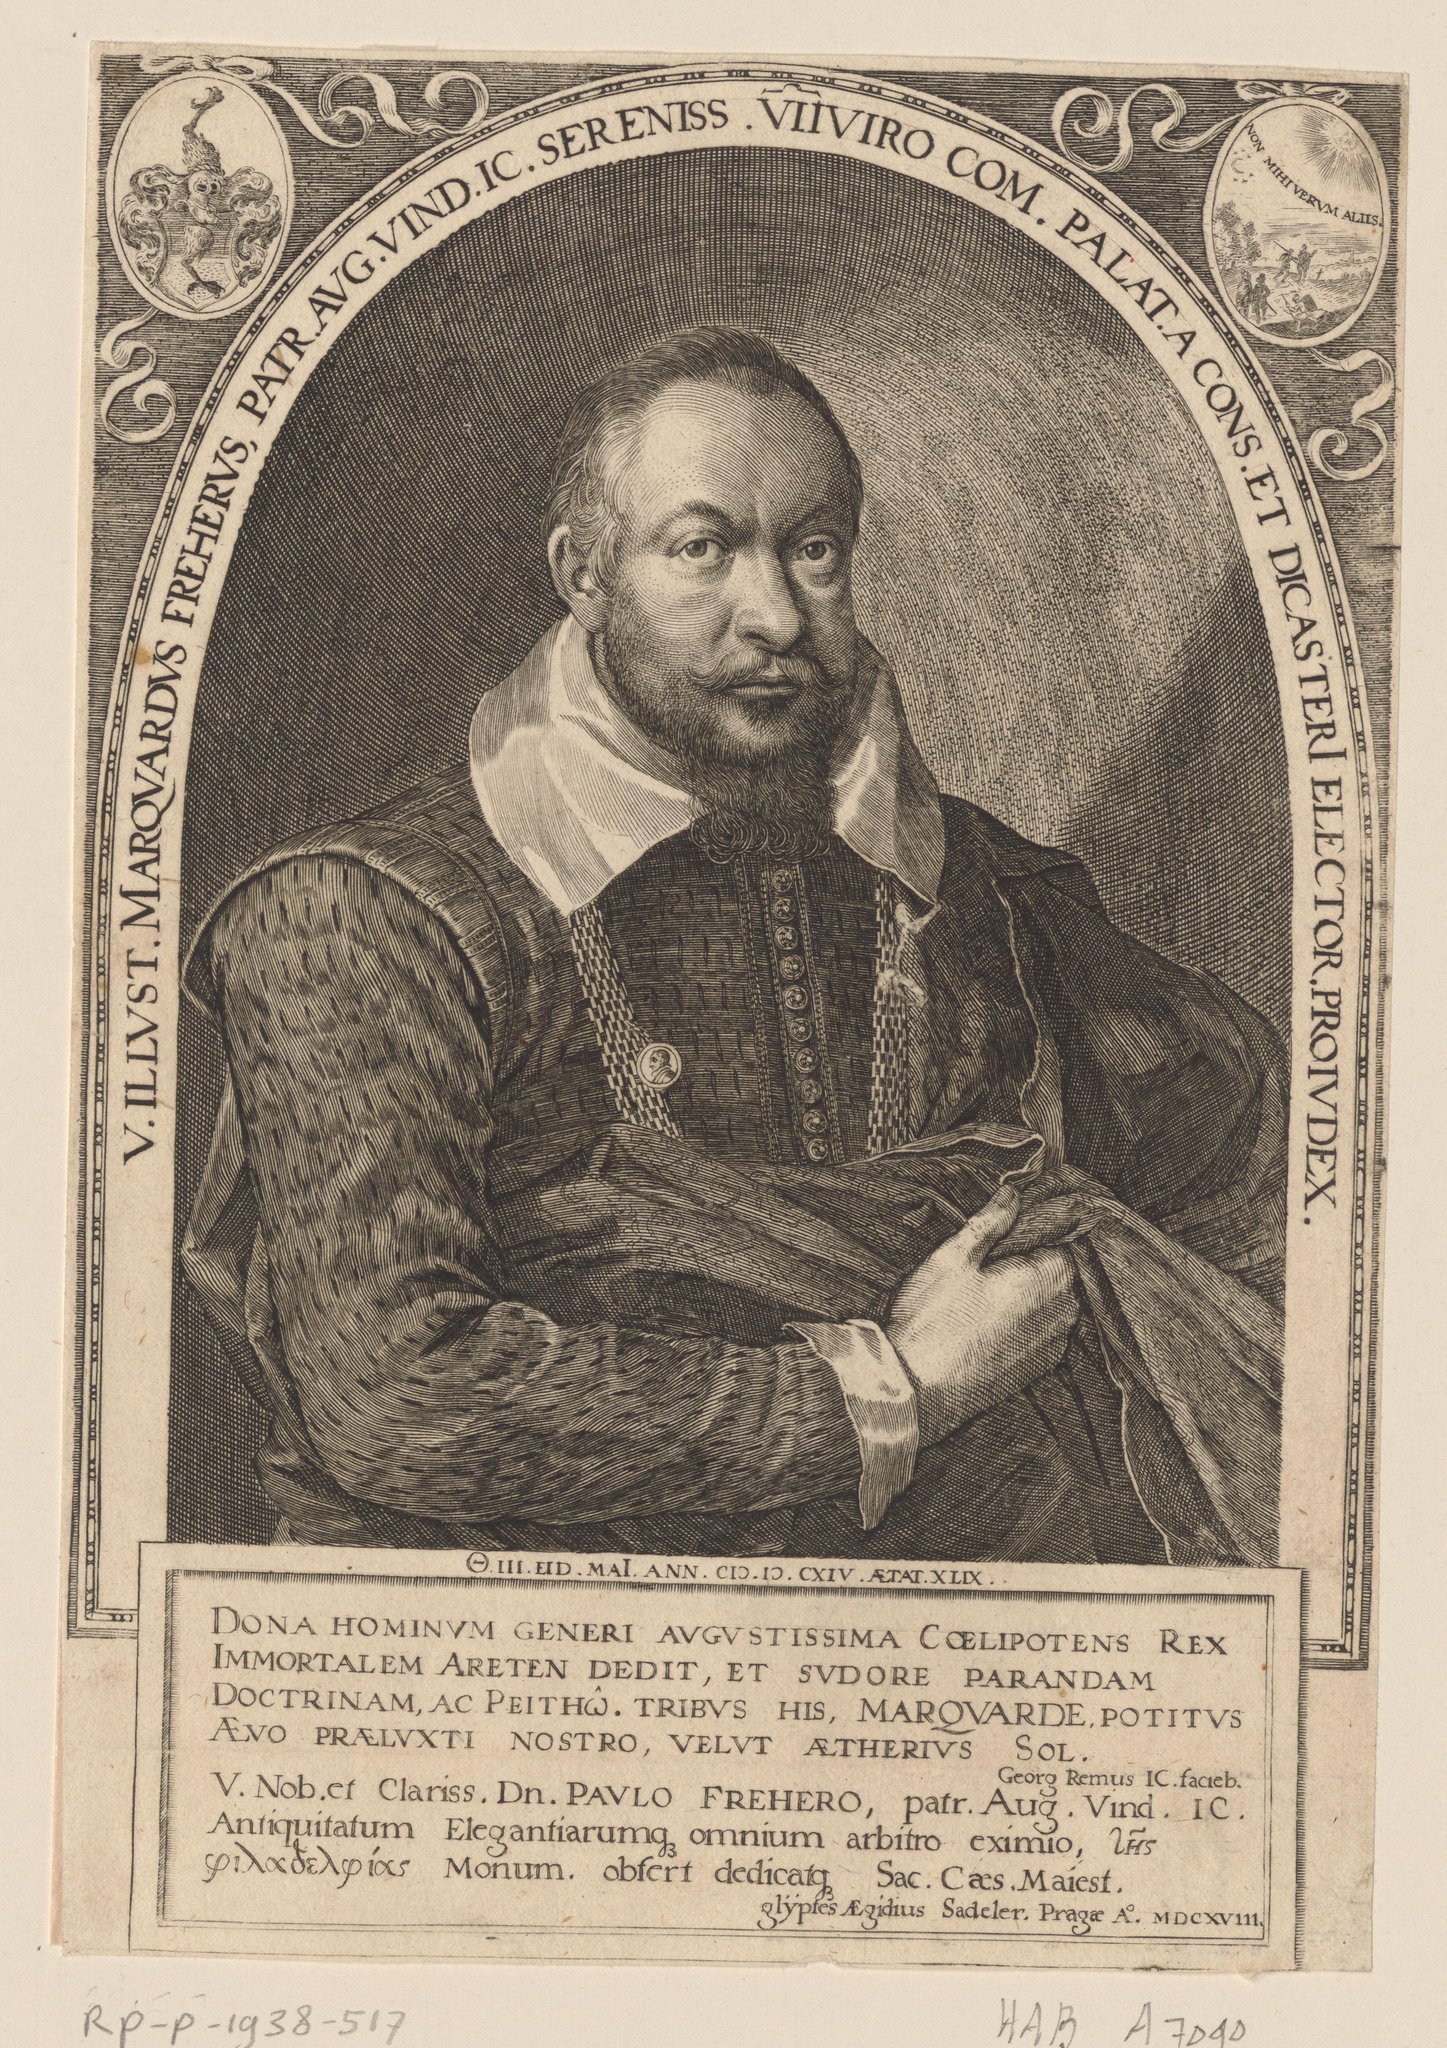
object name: print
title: Portret van Marquard Freher op 49-jarige leeftijd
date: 1618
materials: paper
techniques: engraving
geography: prague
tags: augsburg, historical persons, armorial bearing, heraldry (...) - device, motto, armorial bearing, heraldry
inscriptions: number: ‘55’, collector's mark: Lugt 2228